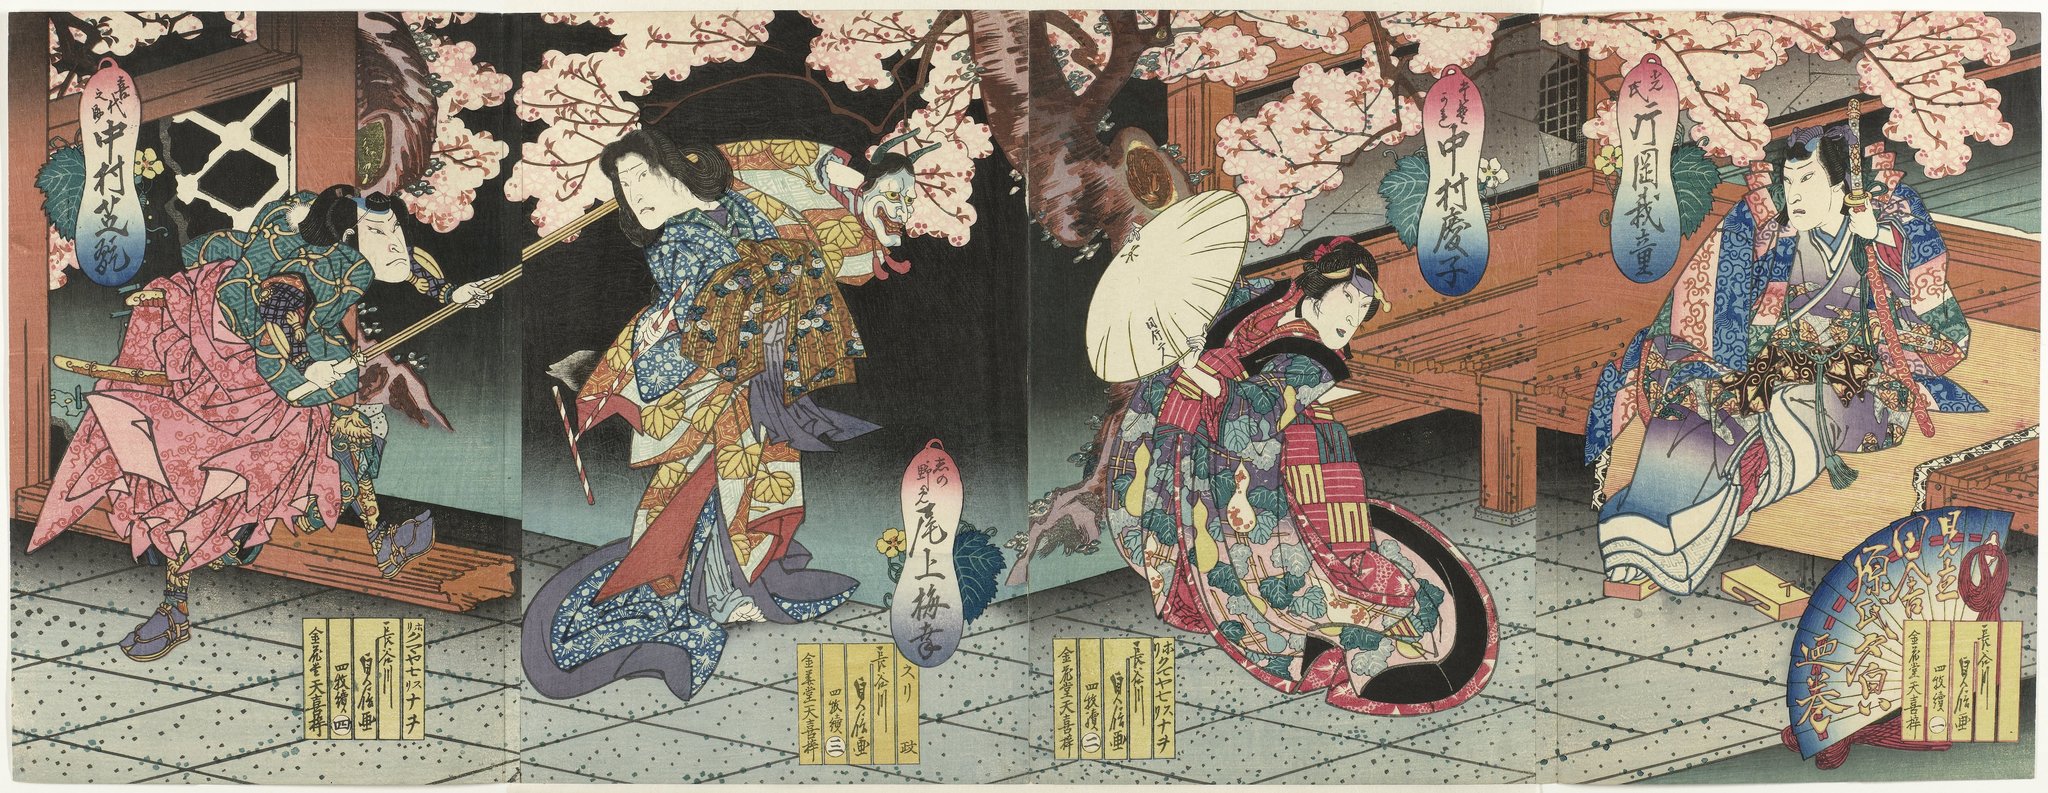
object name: print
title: Vier toneelspelers onder kersenbloesem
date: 1803-1841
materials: paper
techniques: woodcut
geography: osaka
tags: flowers, group of actors, troupe; actors on the stage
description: Vier toneelspelers onder een bloeiende kersenboom. Van links naar rechts: Kataoka Gadô II in de rol van Hikaru Uji die Tasogare, gespeeld door Nakamura Keishi (Tomijûrô II) aanvalt. Acteur Onoe Baikô (Kikugorô III) in de rol van Shinonome met hoed voor het gezicht en Nakamura Shikan III in de rol van Kiyonosuke, zittend op een veranda. Scene uit het toneelstuk "Inakagenji yûgao no maki". Vierluik.